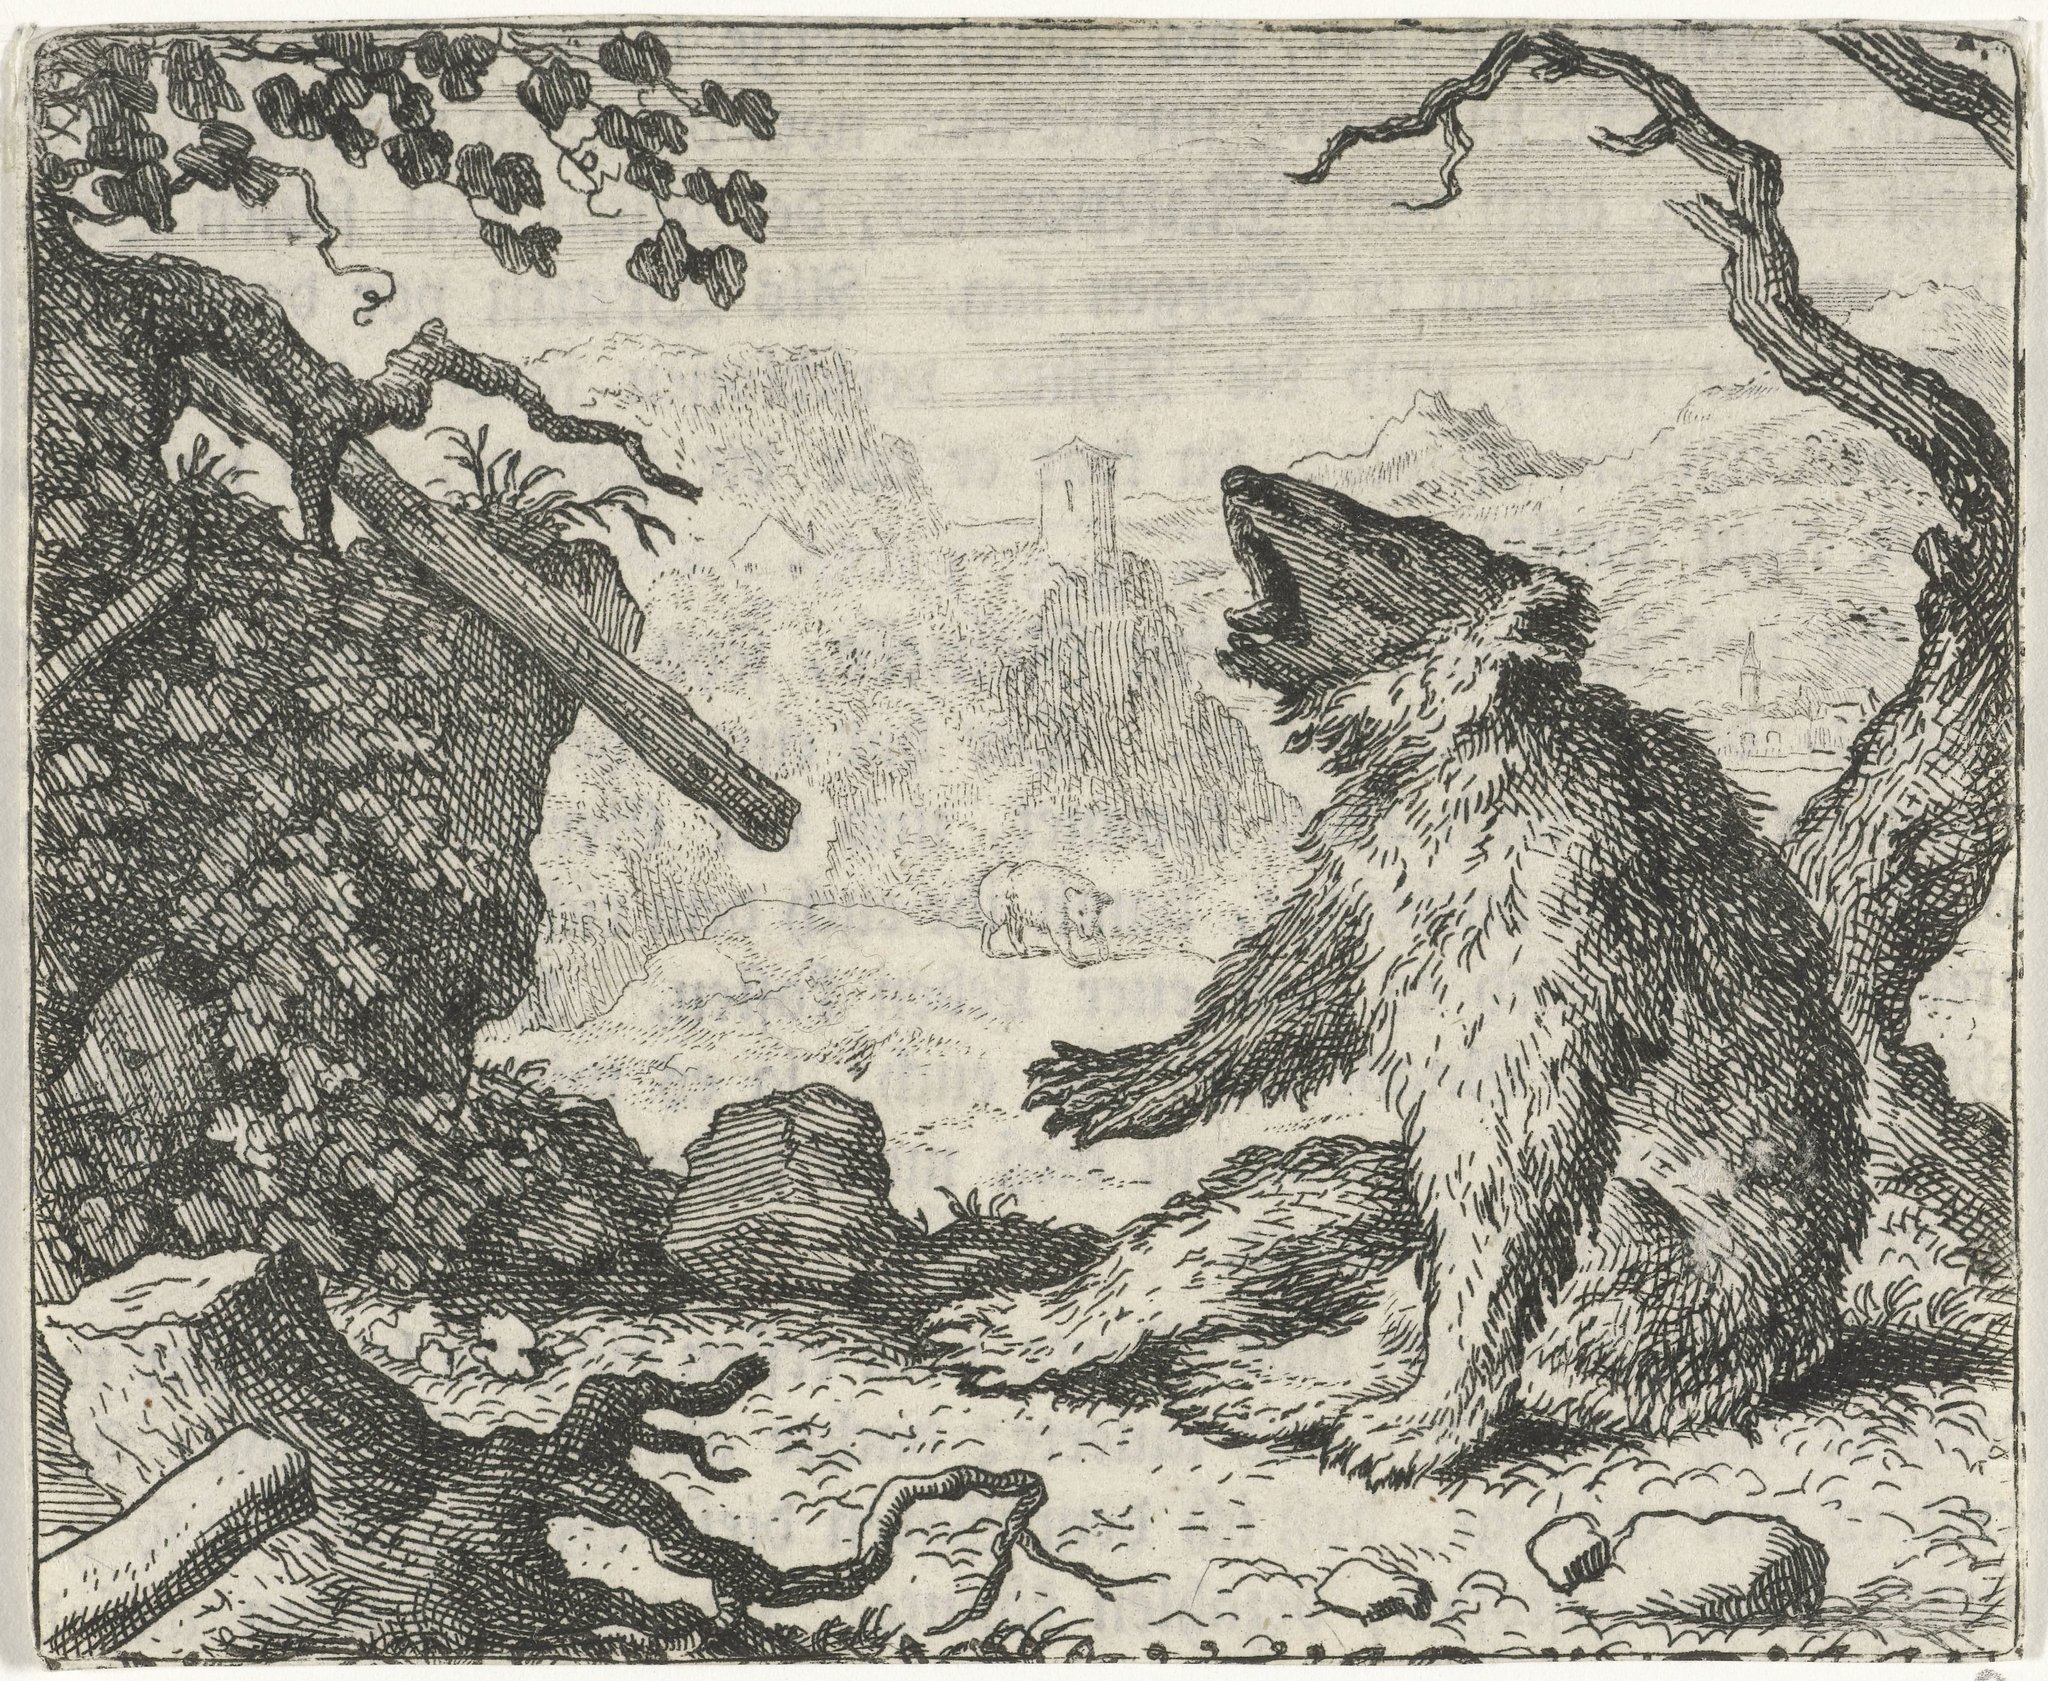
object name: print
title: Bruin de beer dagvaardt Reinaert de vos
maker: allaert van everdingen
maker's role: draughtsman, painter, print maker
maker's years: 1621-1675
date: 1665-1675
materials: paper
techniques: etching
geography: netherlands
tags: fable of reynard the fox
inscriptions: collector's mark: Lugt 2228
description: Bruun de beer zit met opengesperde muil voor het hol van Reinaert de vos. Onder de boomwortels, tussen de klimop bladeren is de kop van de vos zichtbaar. Op de achterkant van de prent een Duits tekstfragment uit het verhaal van Reinaert de vos.